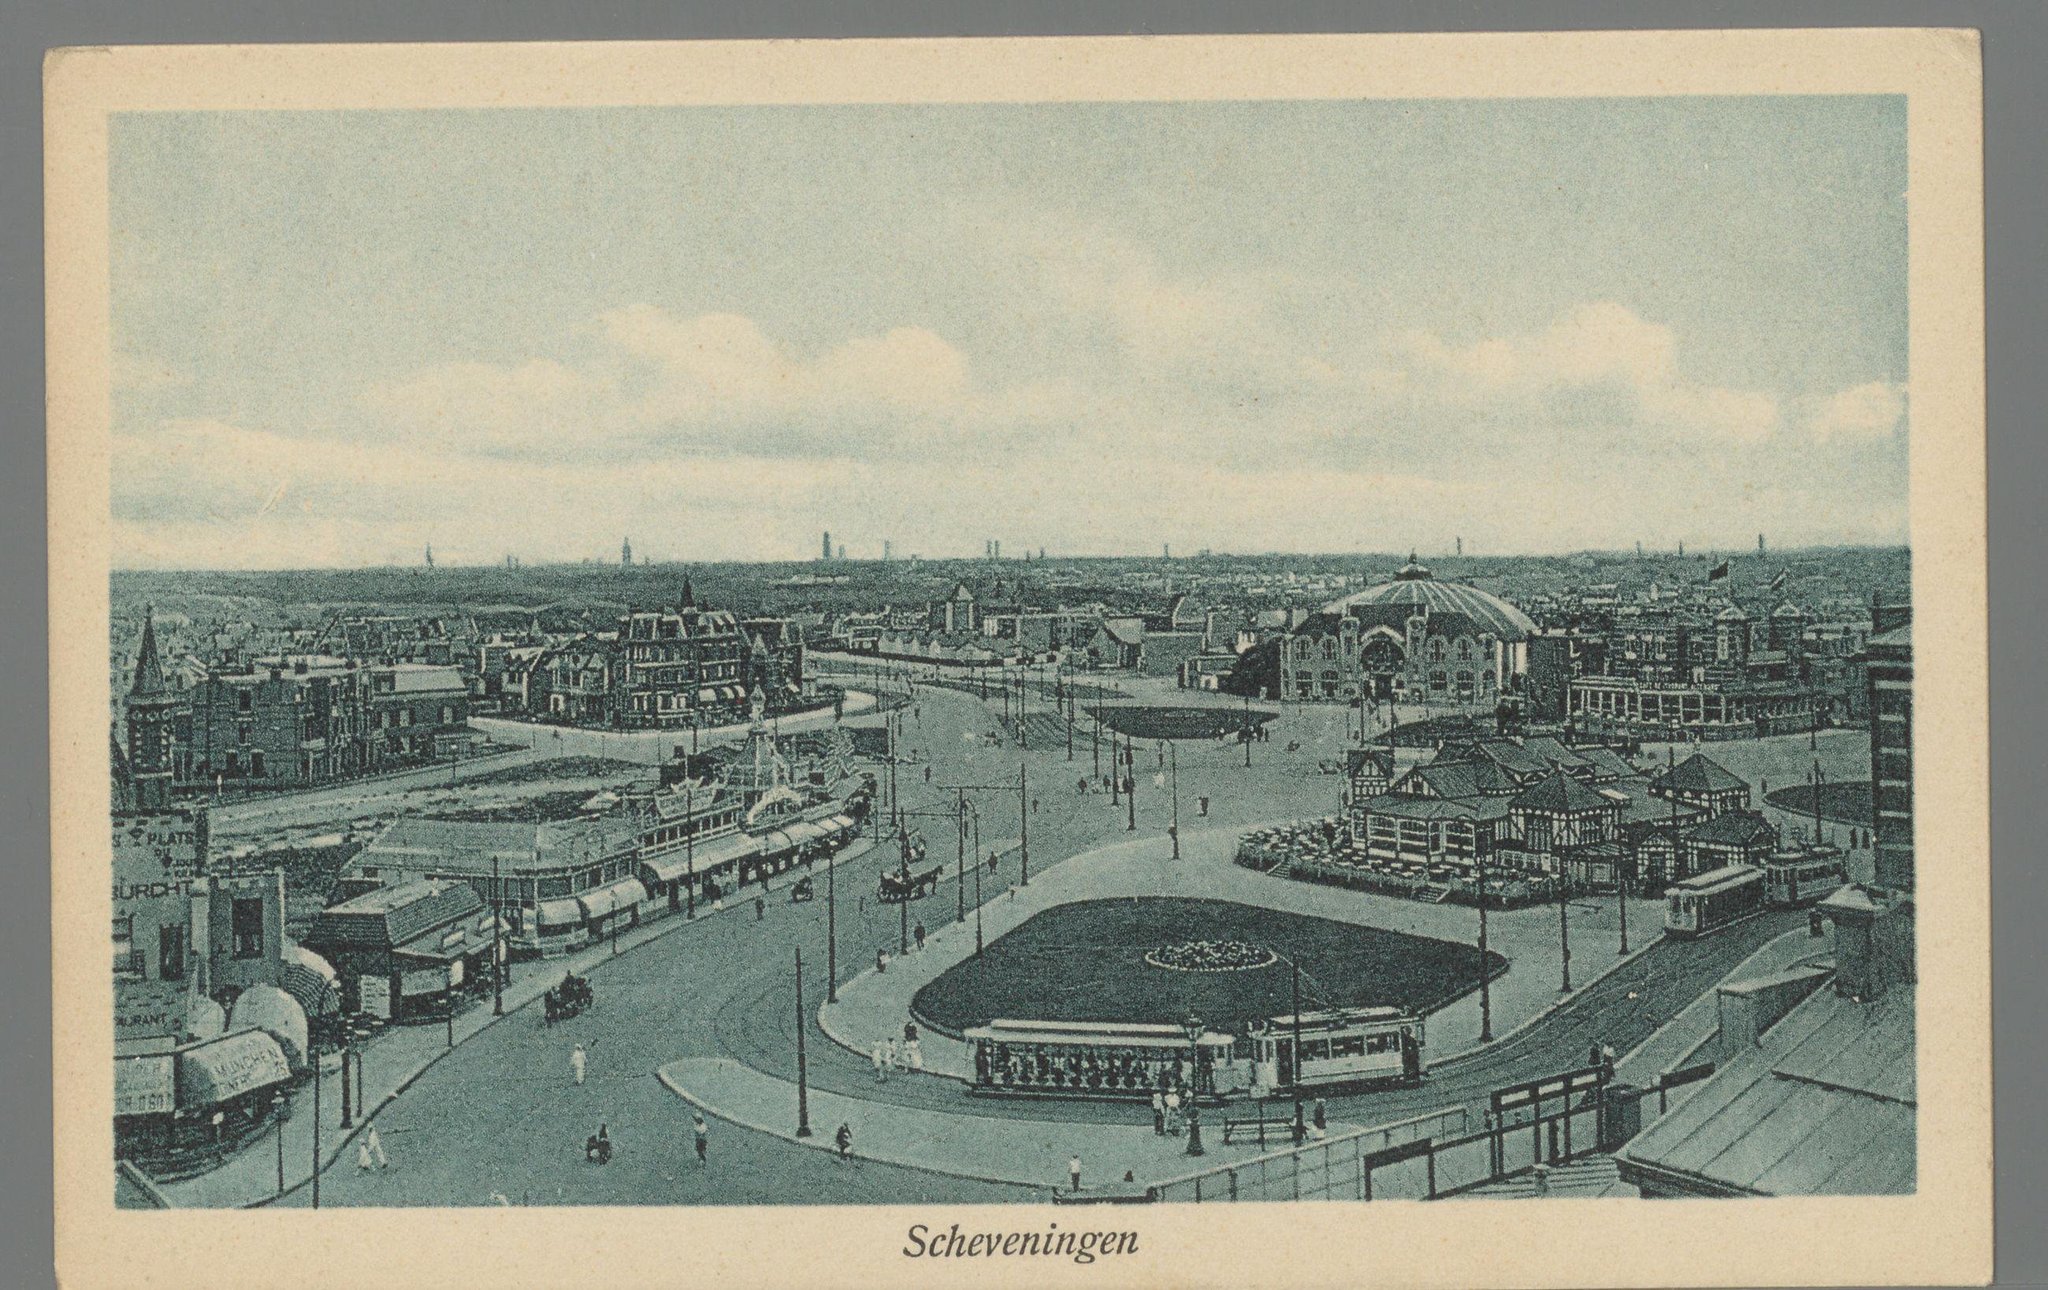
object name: ansichtkaart, prentbriefkaart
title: Scheveningen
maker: Anonymous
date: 1913-1930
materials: cardboard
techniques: photograph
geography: scheveningen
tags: square, place, circus, etc., tram